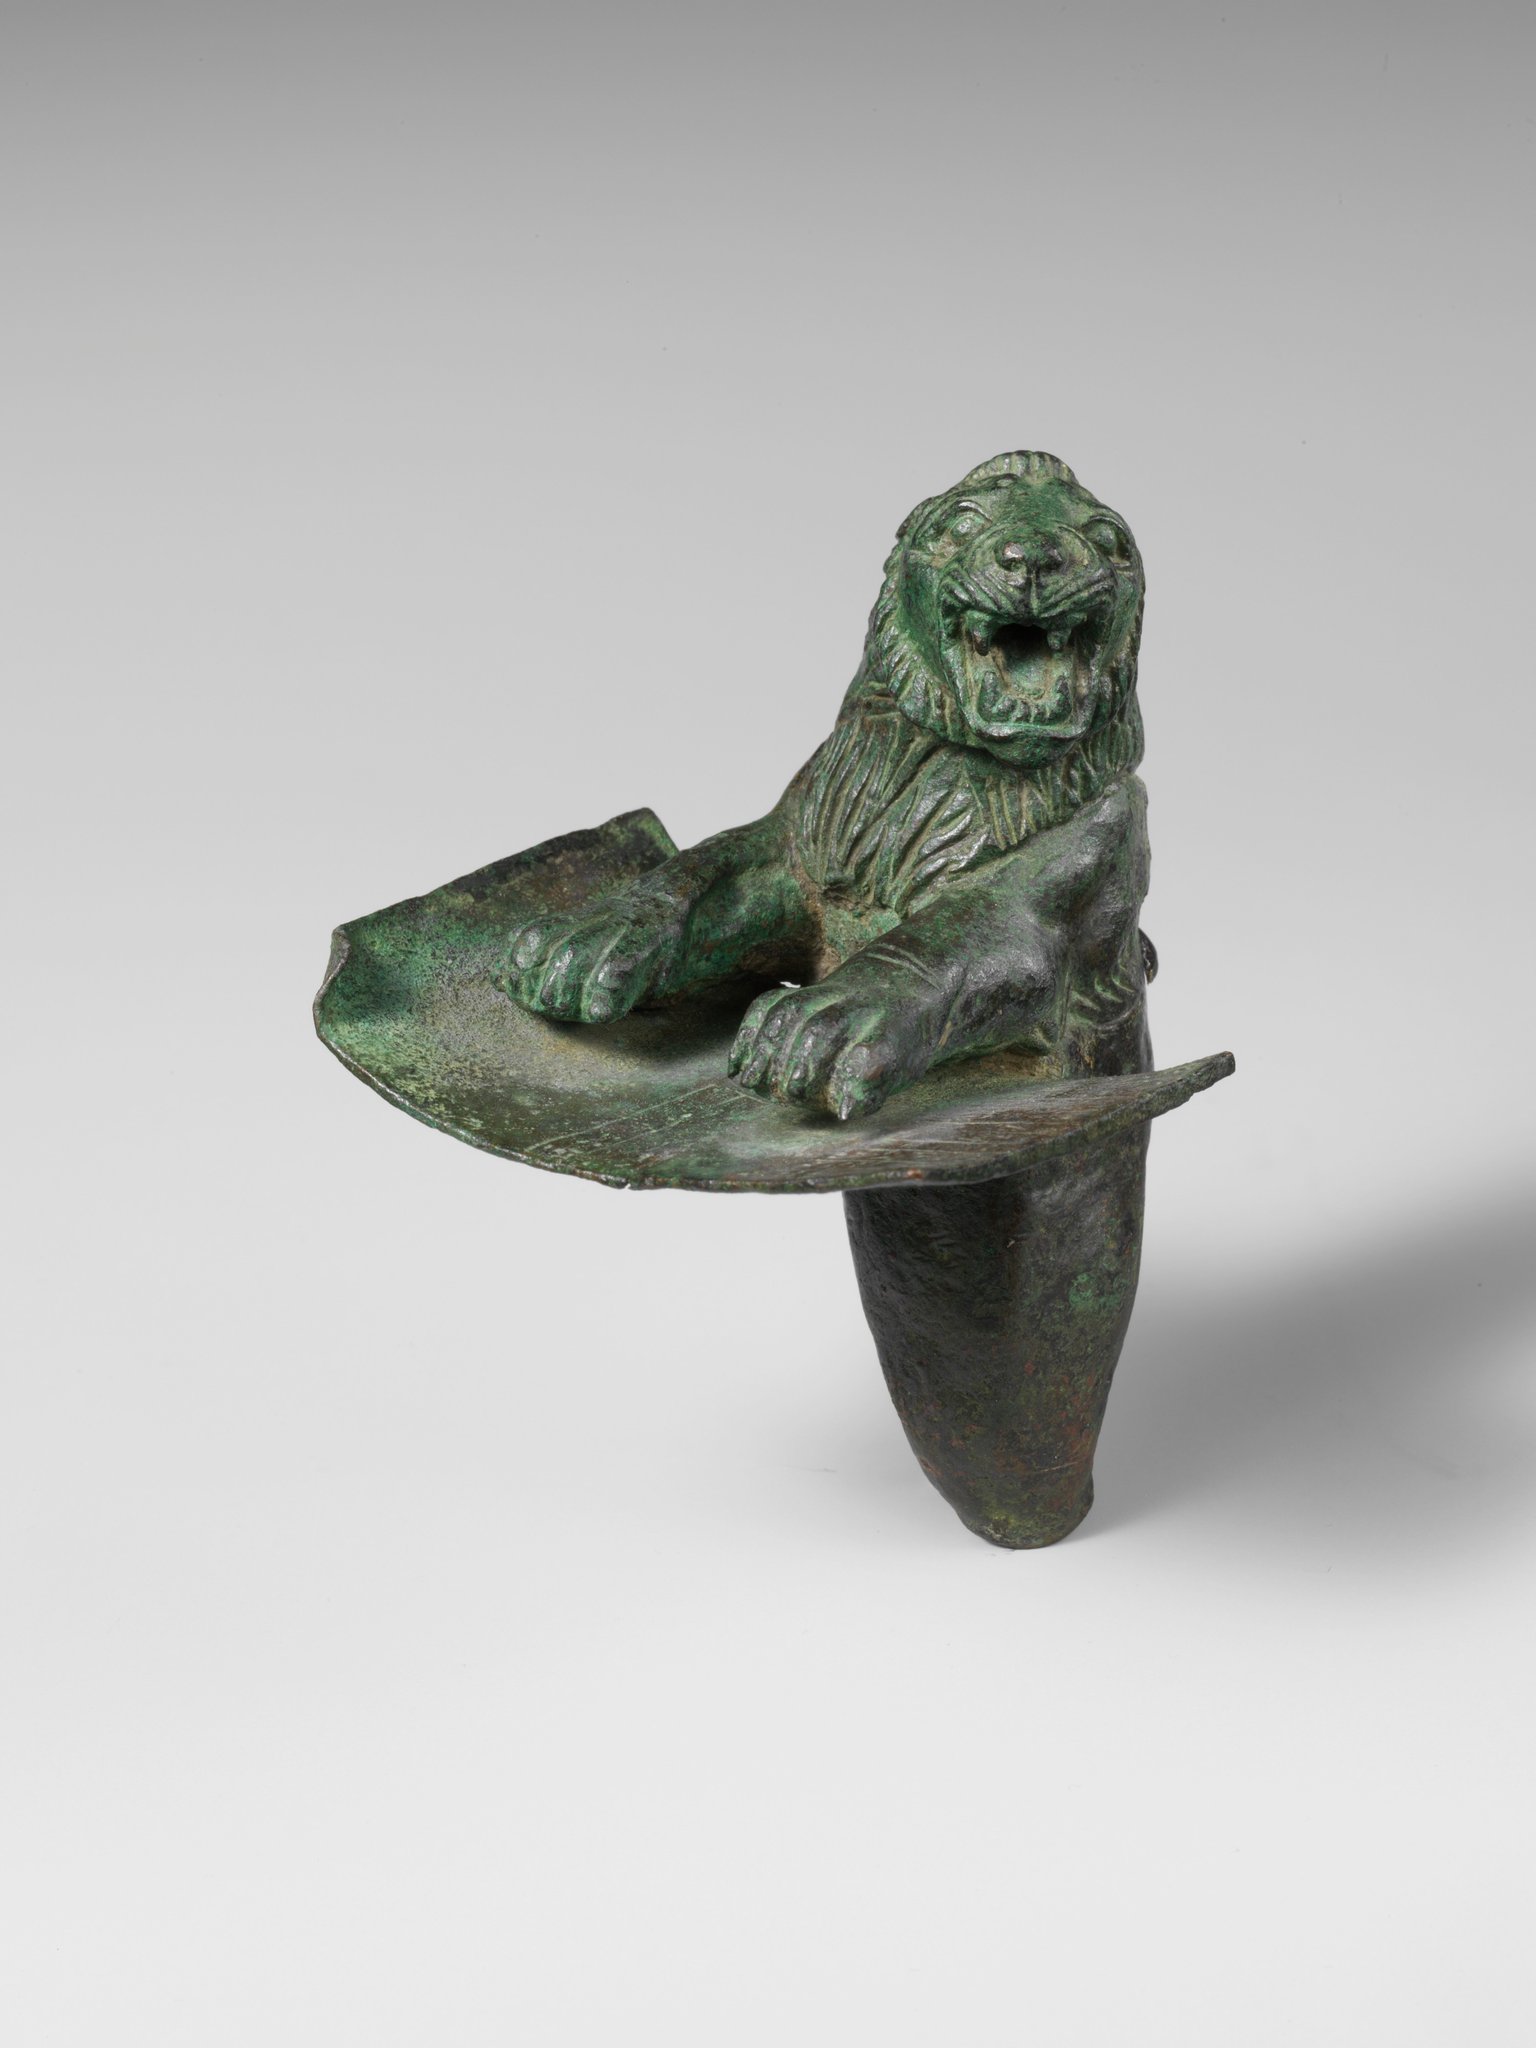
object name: foundation peg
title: Foundation peg in the form of the forepart of a lion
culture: hurrian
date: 2200-2100 BCE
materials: copper alloy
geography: syria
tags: lions